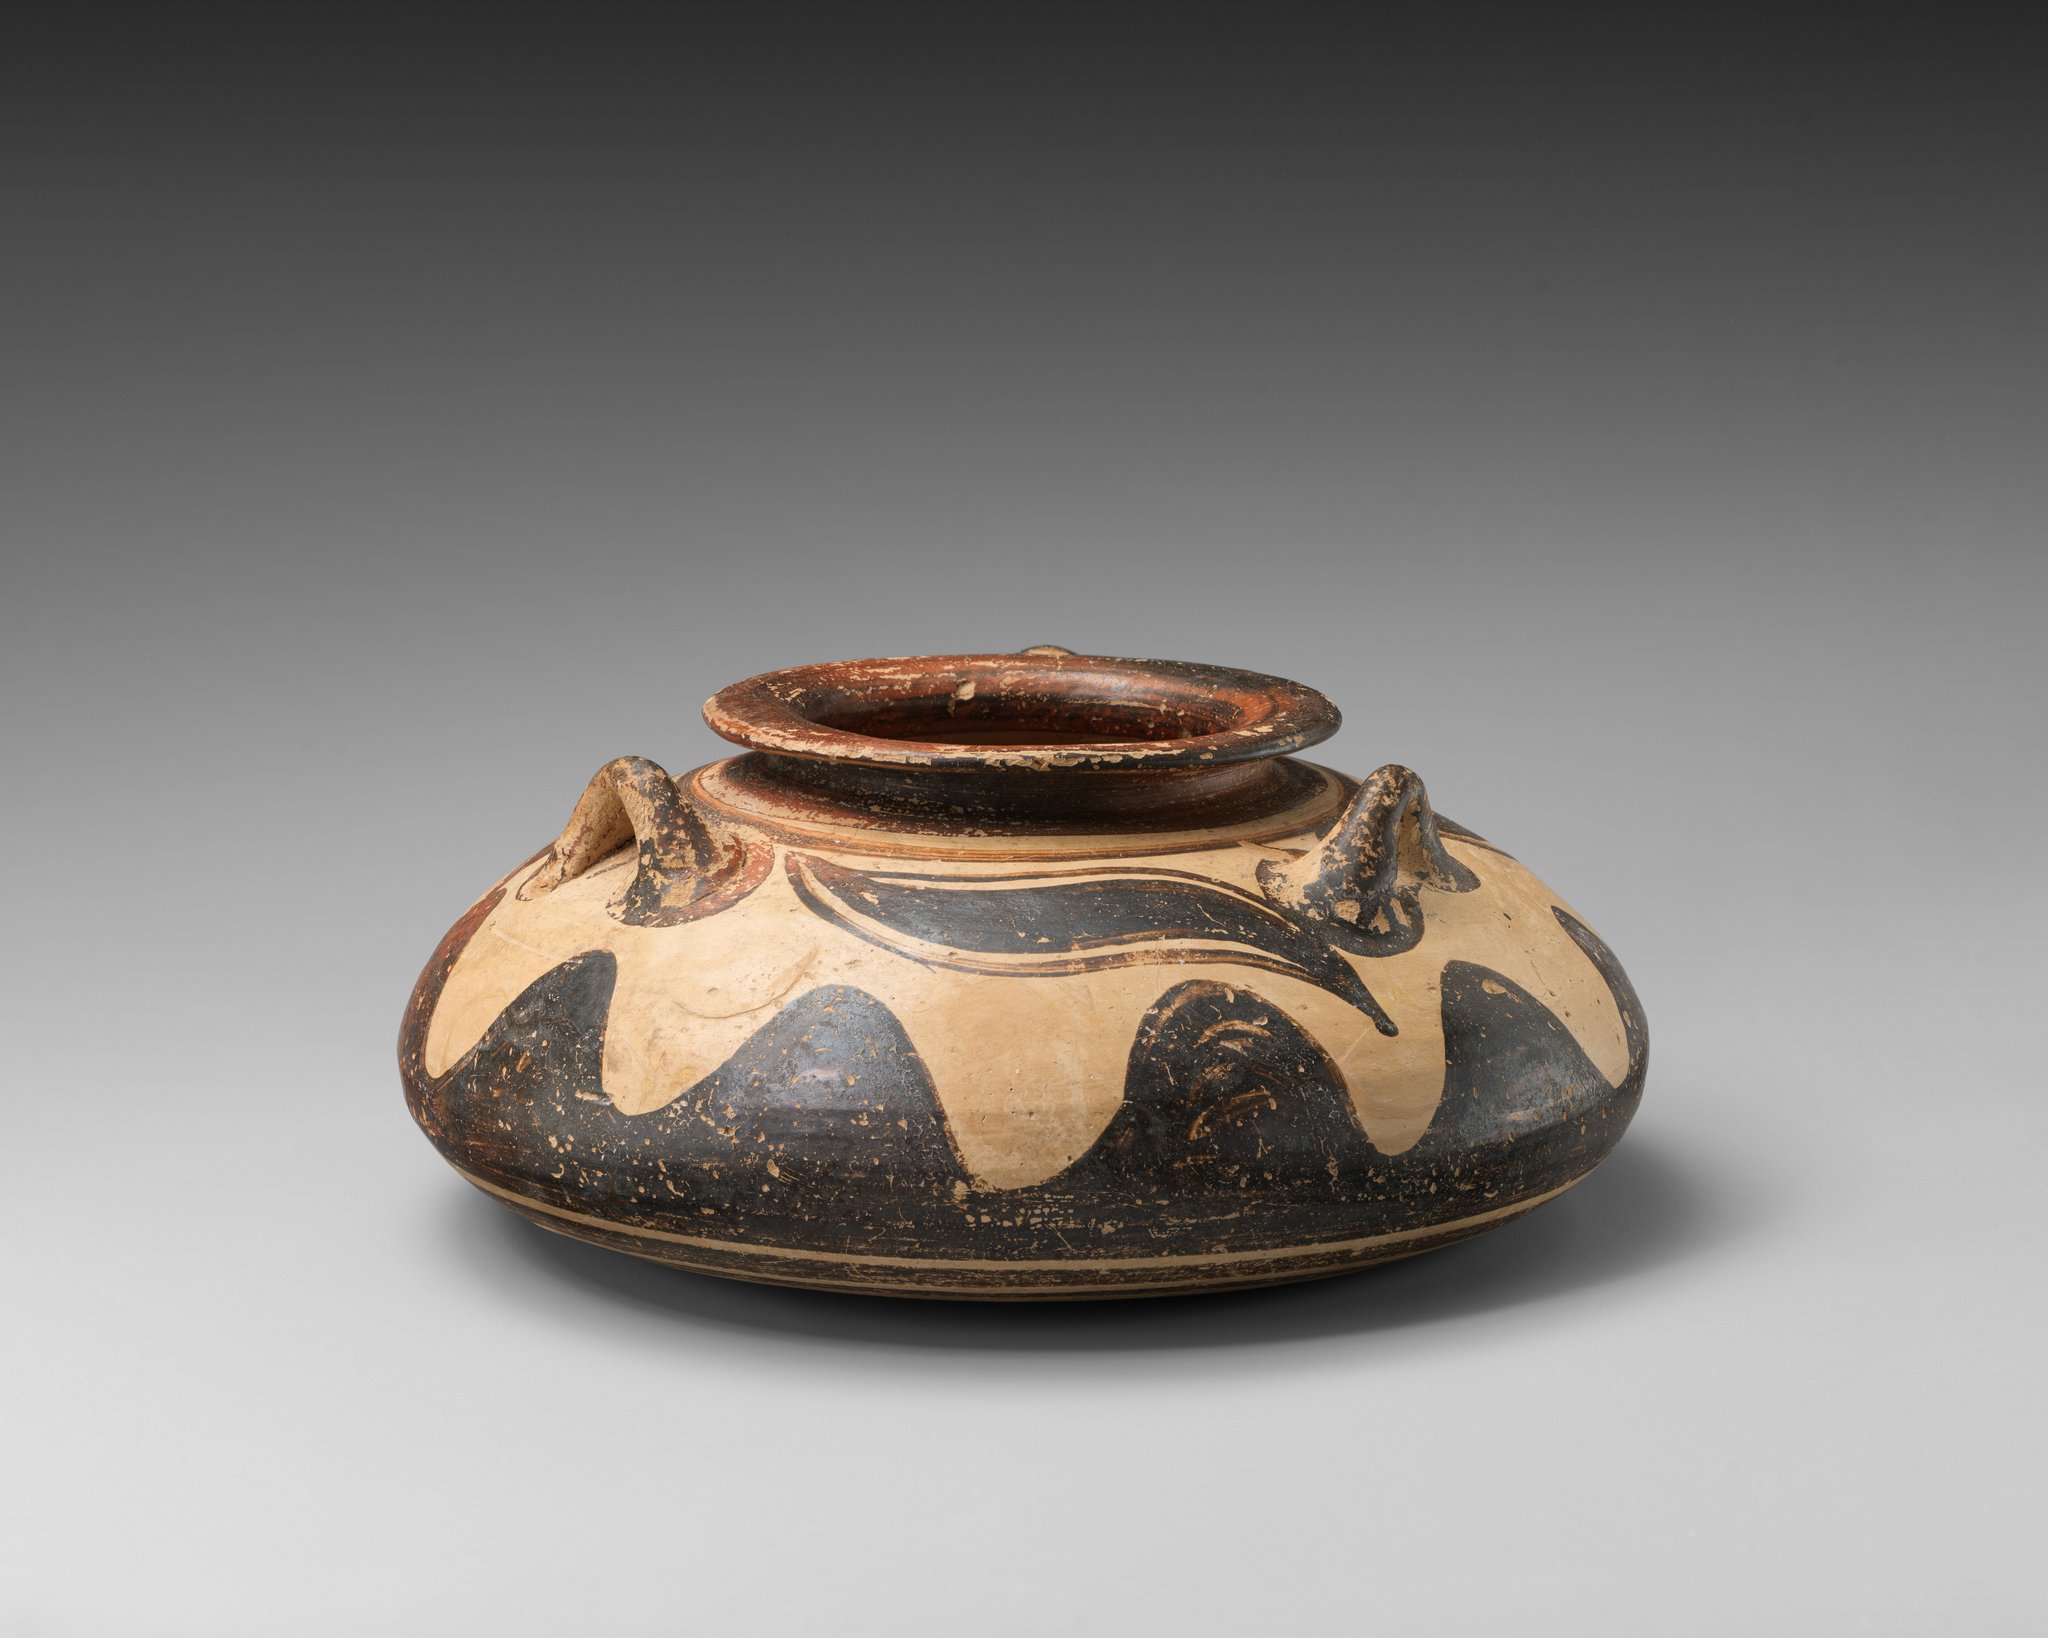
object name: jar, squat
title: Terracotta squat jar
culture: cypriot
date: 1500-1401 BCE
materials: terracotta